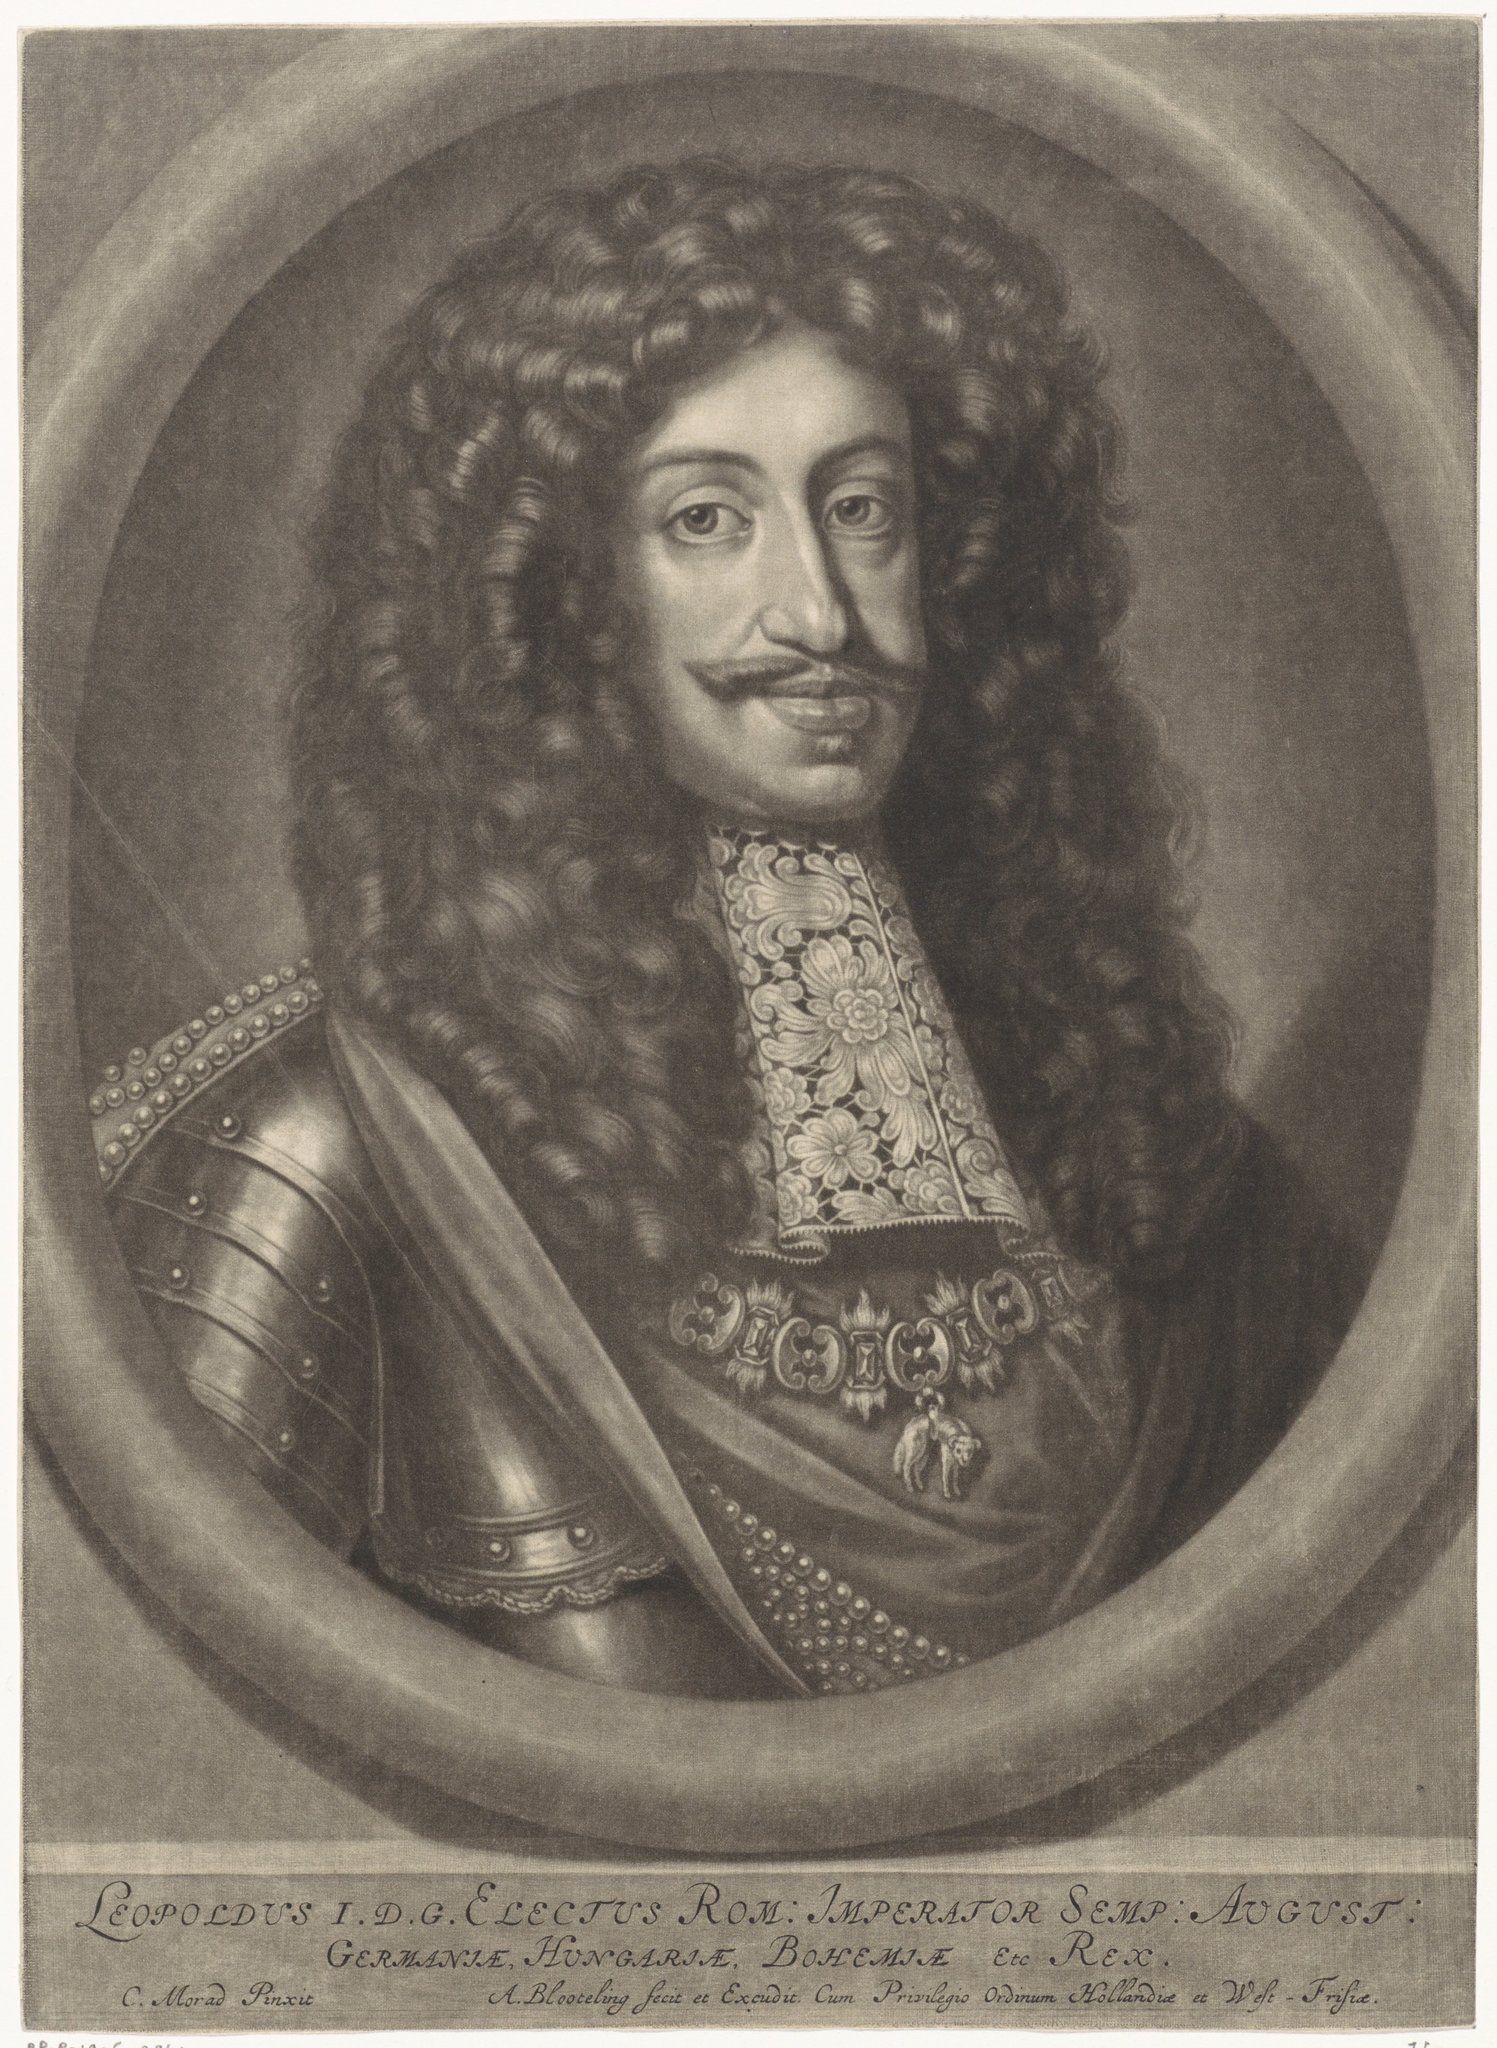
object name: print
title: Portret van keizer Leopold I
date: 1660-1690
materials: paper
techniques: engraving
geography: amsterdam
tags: vienna, leopold i (keizer van duitsland), knighthood order of the golden fleece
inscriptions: collector's mark: Lugt 2228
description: Portret van Leopold I, keizer van het Heilig Roomse Rijk, aartshertog van Oostenrijk en koning van Hongarije. Hij draagt een harnas en heeft om zijn hals een keten met het ordeteken van het Gulden Vlies. De prent heeft een Latijns onderschrift met de naam en de titels van de geportretteerde.